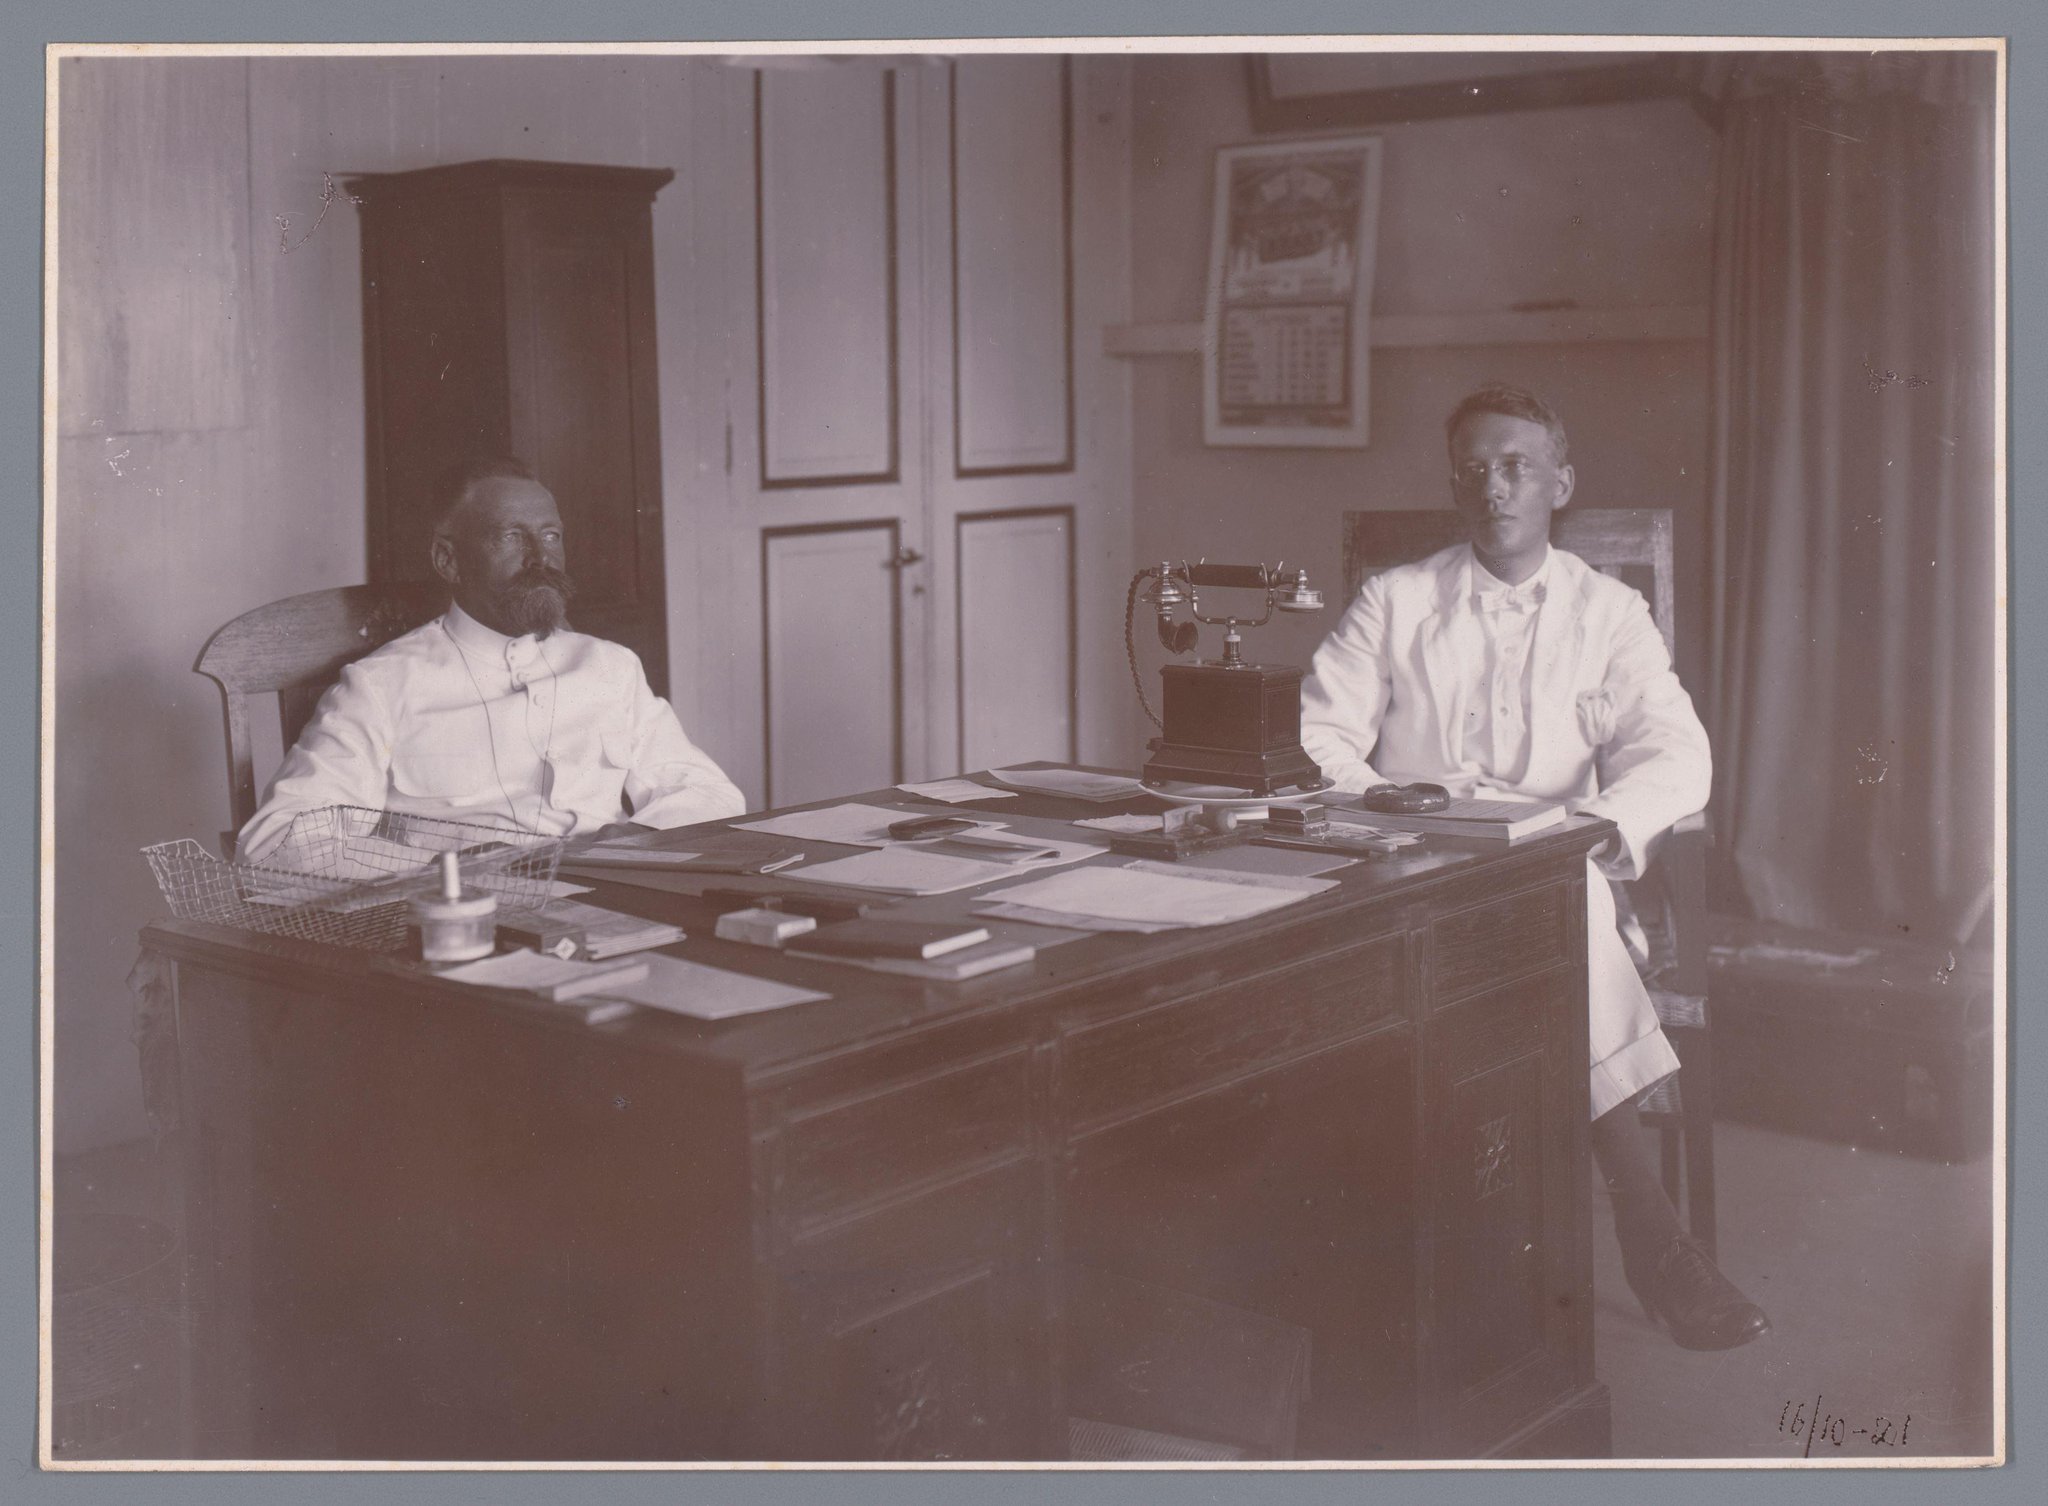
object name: photograph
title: Oceaanhaven Belawan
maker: Anonymous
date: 1921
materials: photographic support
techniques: gelatin silver print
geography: belawan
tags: director, boss (in modern industry), historical persons, office (~ administration)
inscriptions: inscription: ‘No 83 / Directeuren Mij Grotius’, date: ‘16/10-21’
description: Interieur met de twee directeuren van de Aanneming Maatschapij Grotius, zittend achter een bureau met telefooon. Links Laurens de Groot, rechts waarschijnlijk P.J.F. van Buuren, oktober 1921. Genummerd: 83. Onderdeel van de groep van losse foto's over de aanleg van de haven Belawan aan de kust voor Medan, Sumatra 1921-1922.